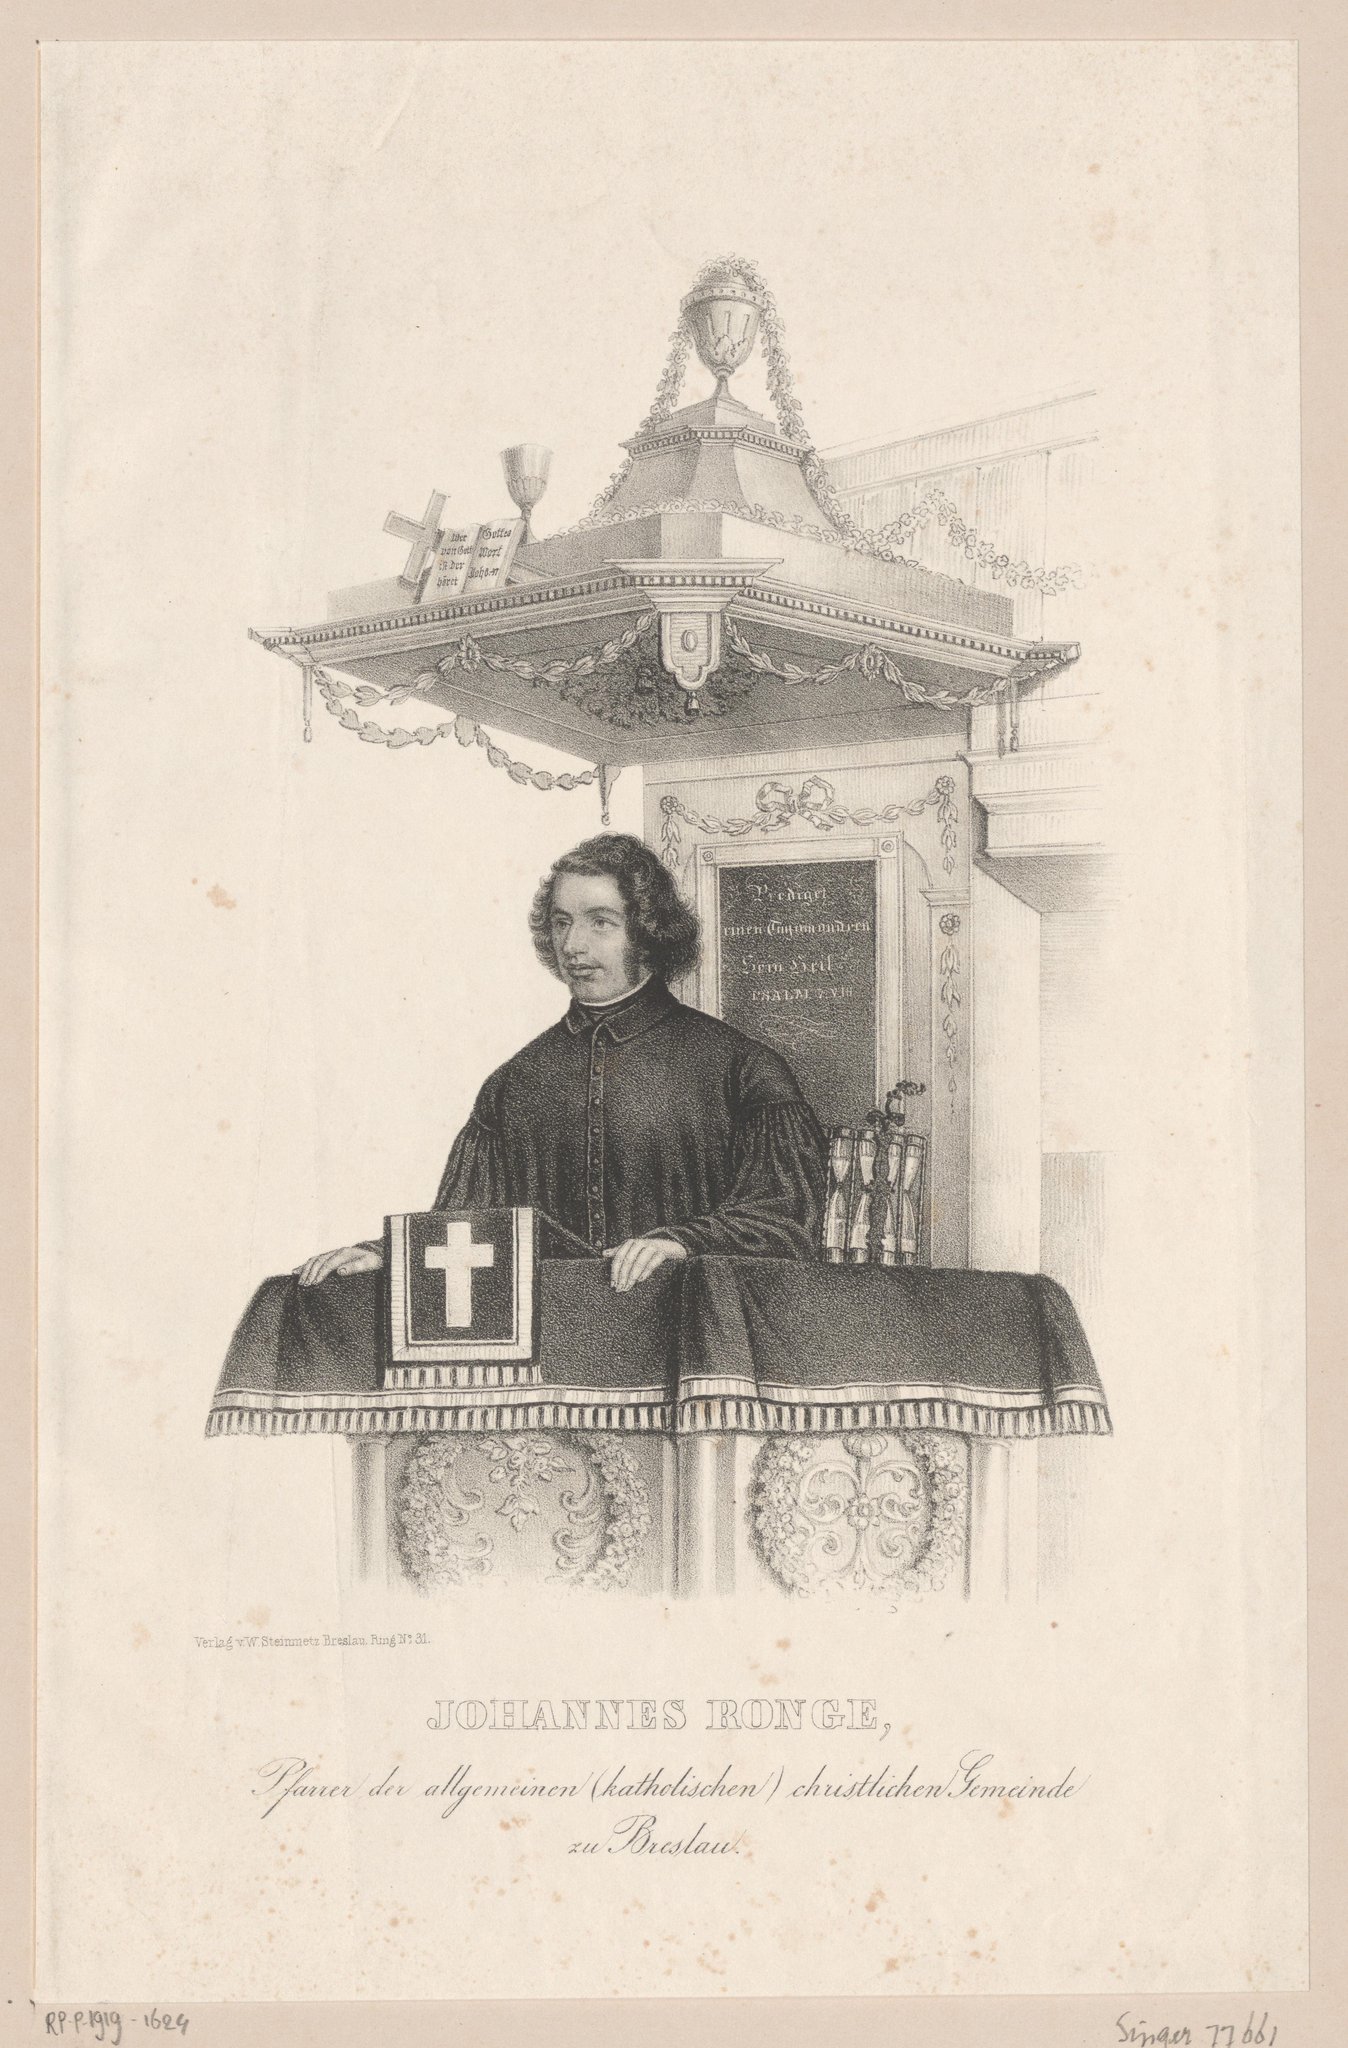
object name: print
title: Portret van Johannes Ronge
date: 1823-1899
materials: paper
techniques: lithograph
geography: breslau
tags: vienna, theologian, historical persons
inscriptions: collector's mark: Lugt 2228